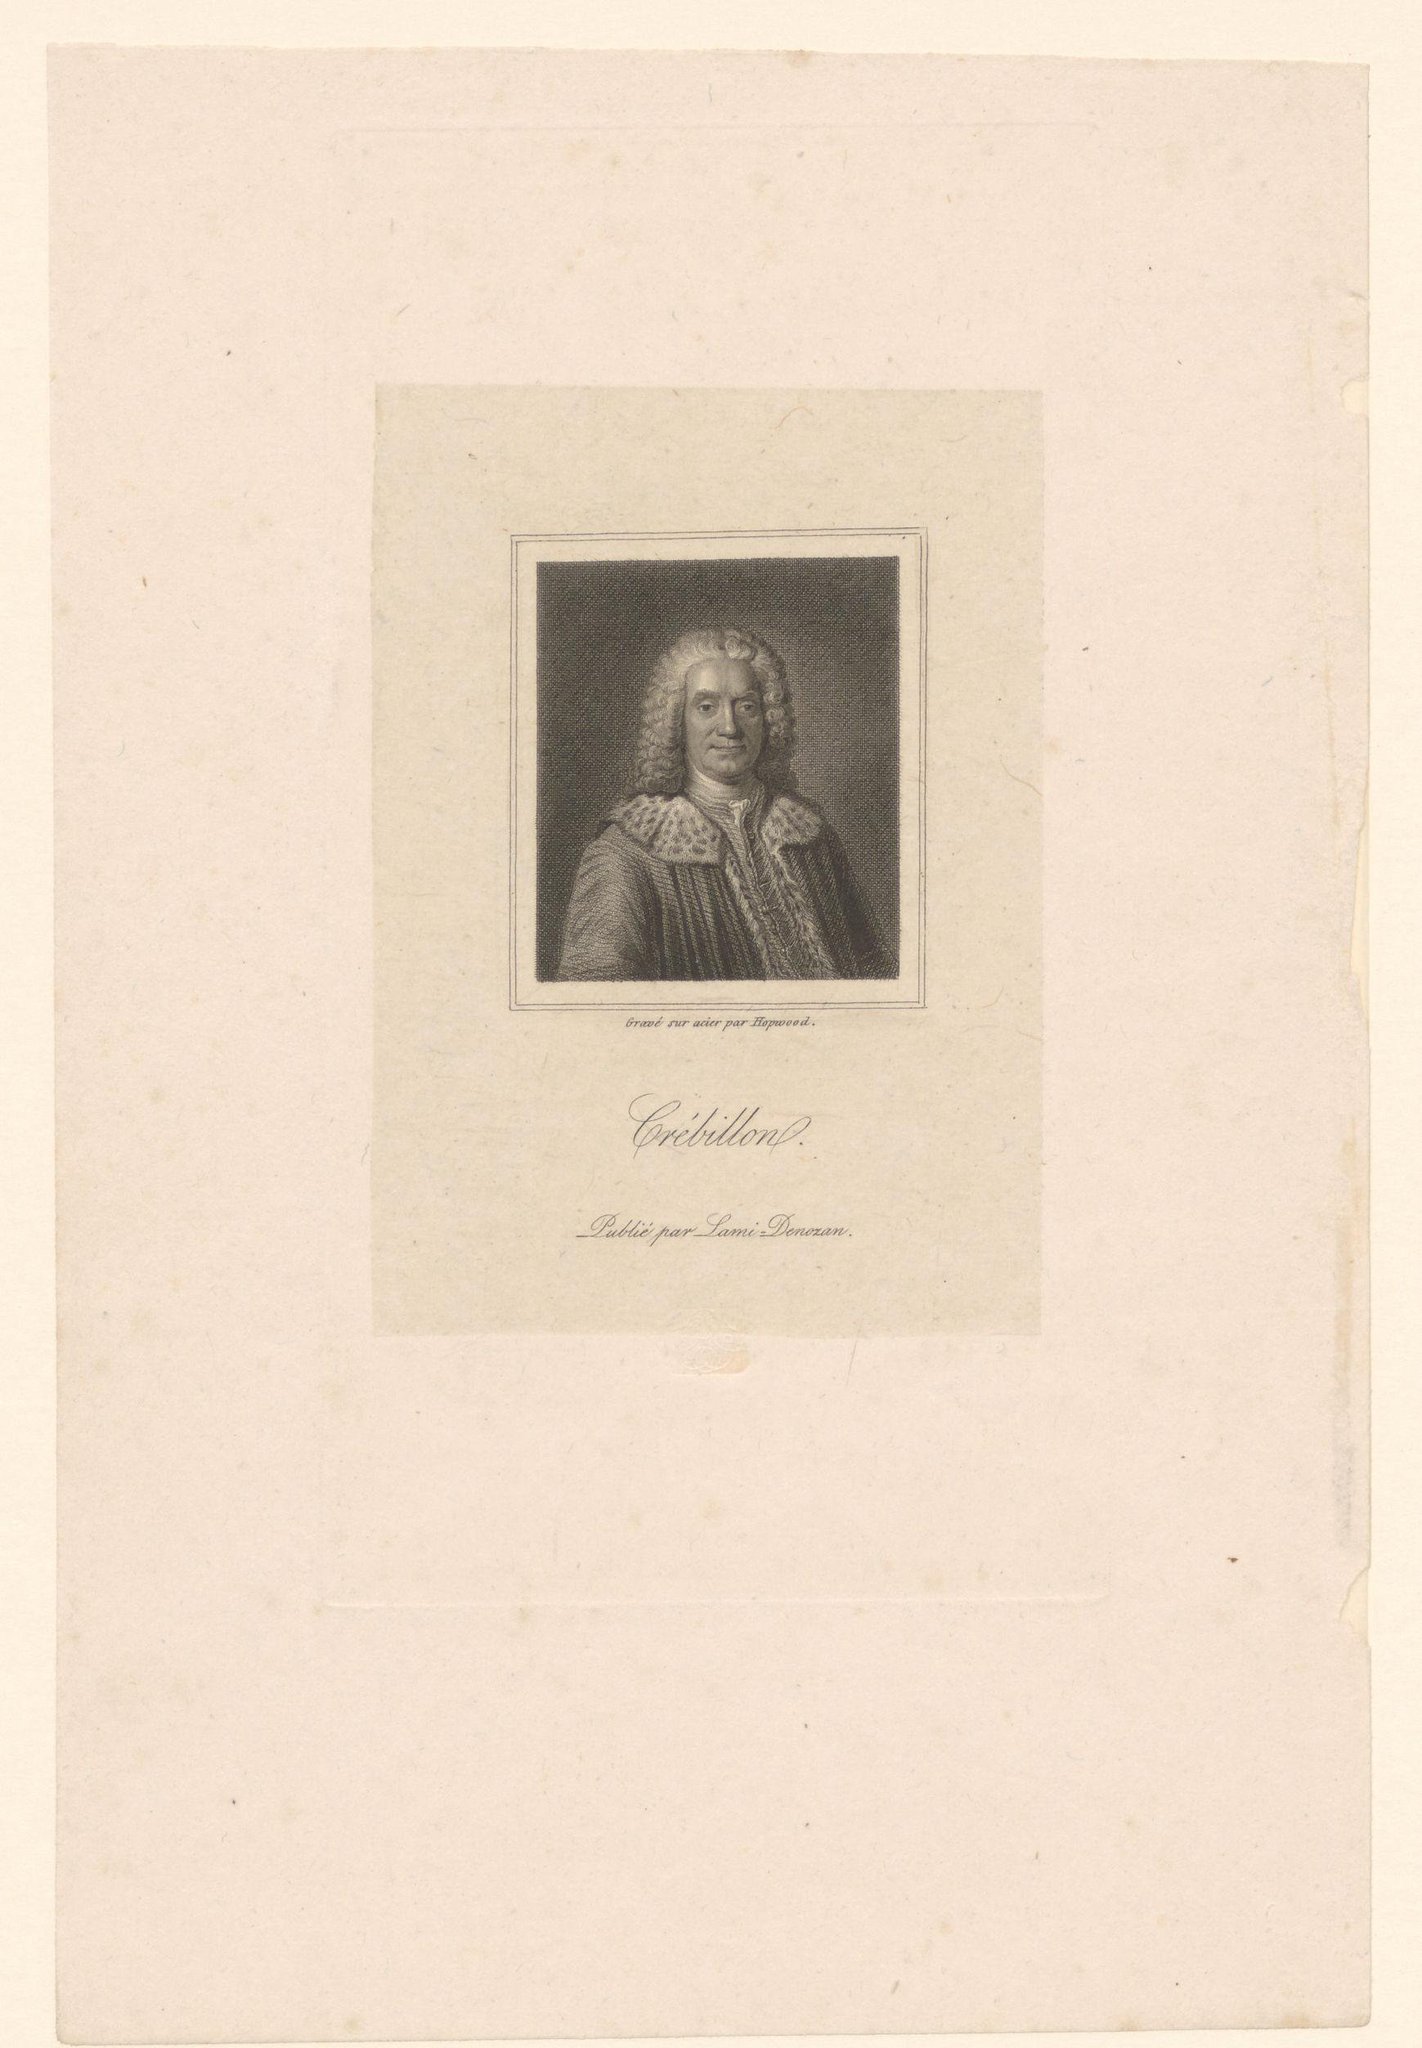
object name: print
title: Crébillon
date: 1828-1850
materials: paper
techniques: etching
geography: paris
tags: historical persons, portrait of a writer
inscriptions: check stamp: ‘A[?]’, collector's mark: Lugt 2228